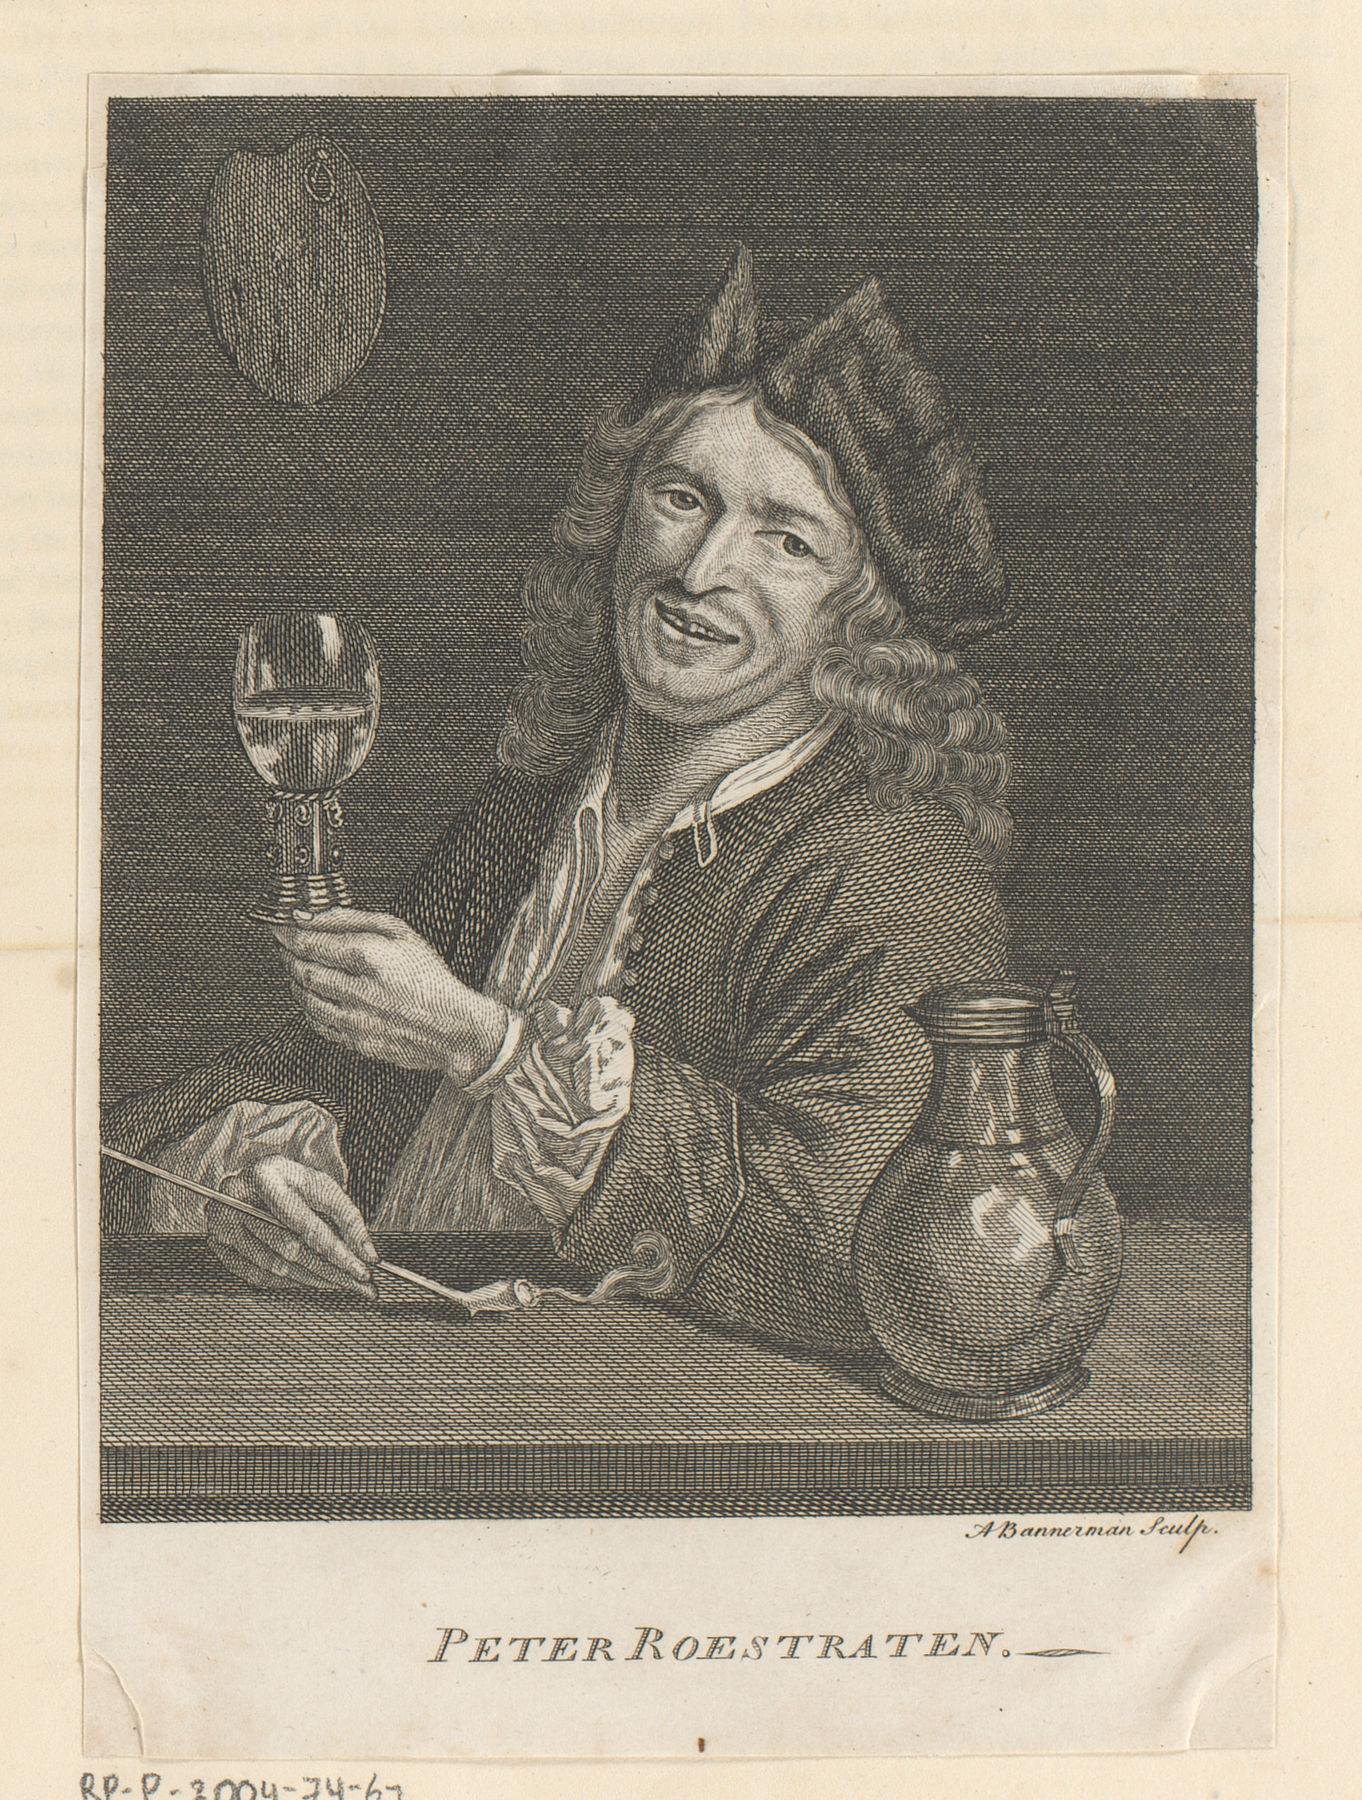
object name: print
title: Peter Roestraten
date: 1762-1789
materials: paper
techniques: engraving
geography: london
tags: haarlem, london, painter, print maker, pieter gerritsz. van roestraeten, historical persons, portrait, self-portrait of painter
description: Prent uit: Walpole, Horace. Anecdotes of painting in England with some account of the principal artists and incidental notes on other arts collected by the late Mr. George Vertue and now digested and published from his original Mss. by Horace Walpole. 4 dln. Londen: Horace Walpole, 1762-1789, dl. 3, p. 42. De samensteller heeft deze prent in het album geplakt als illustratie bij: Pilkington, Matthew en Johann Heinrich Füssli. A dictionary of painters, from the revival of the art to the present period. 4 dln. Londen: John Crowder, 1805, dl. 3, p. 455.